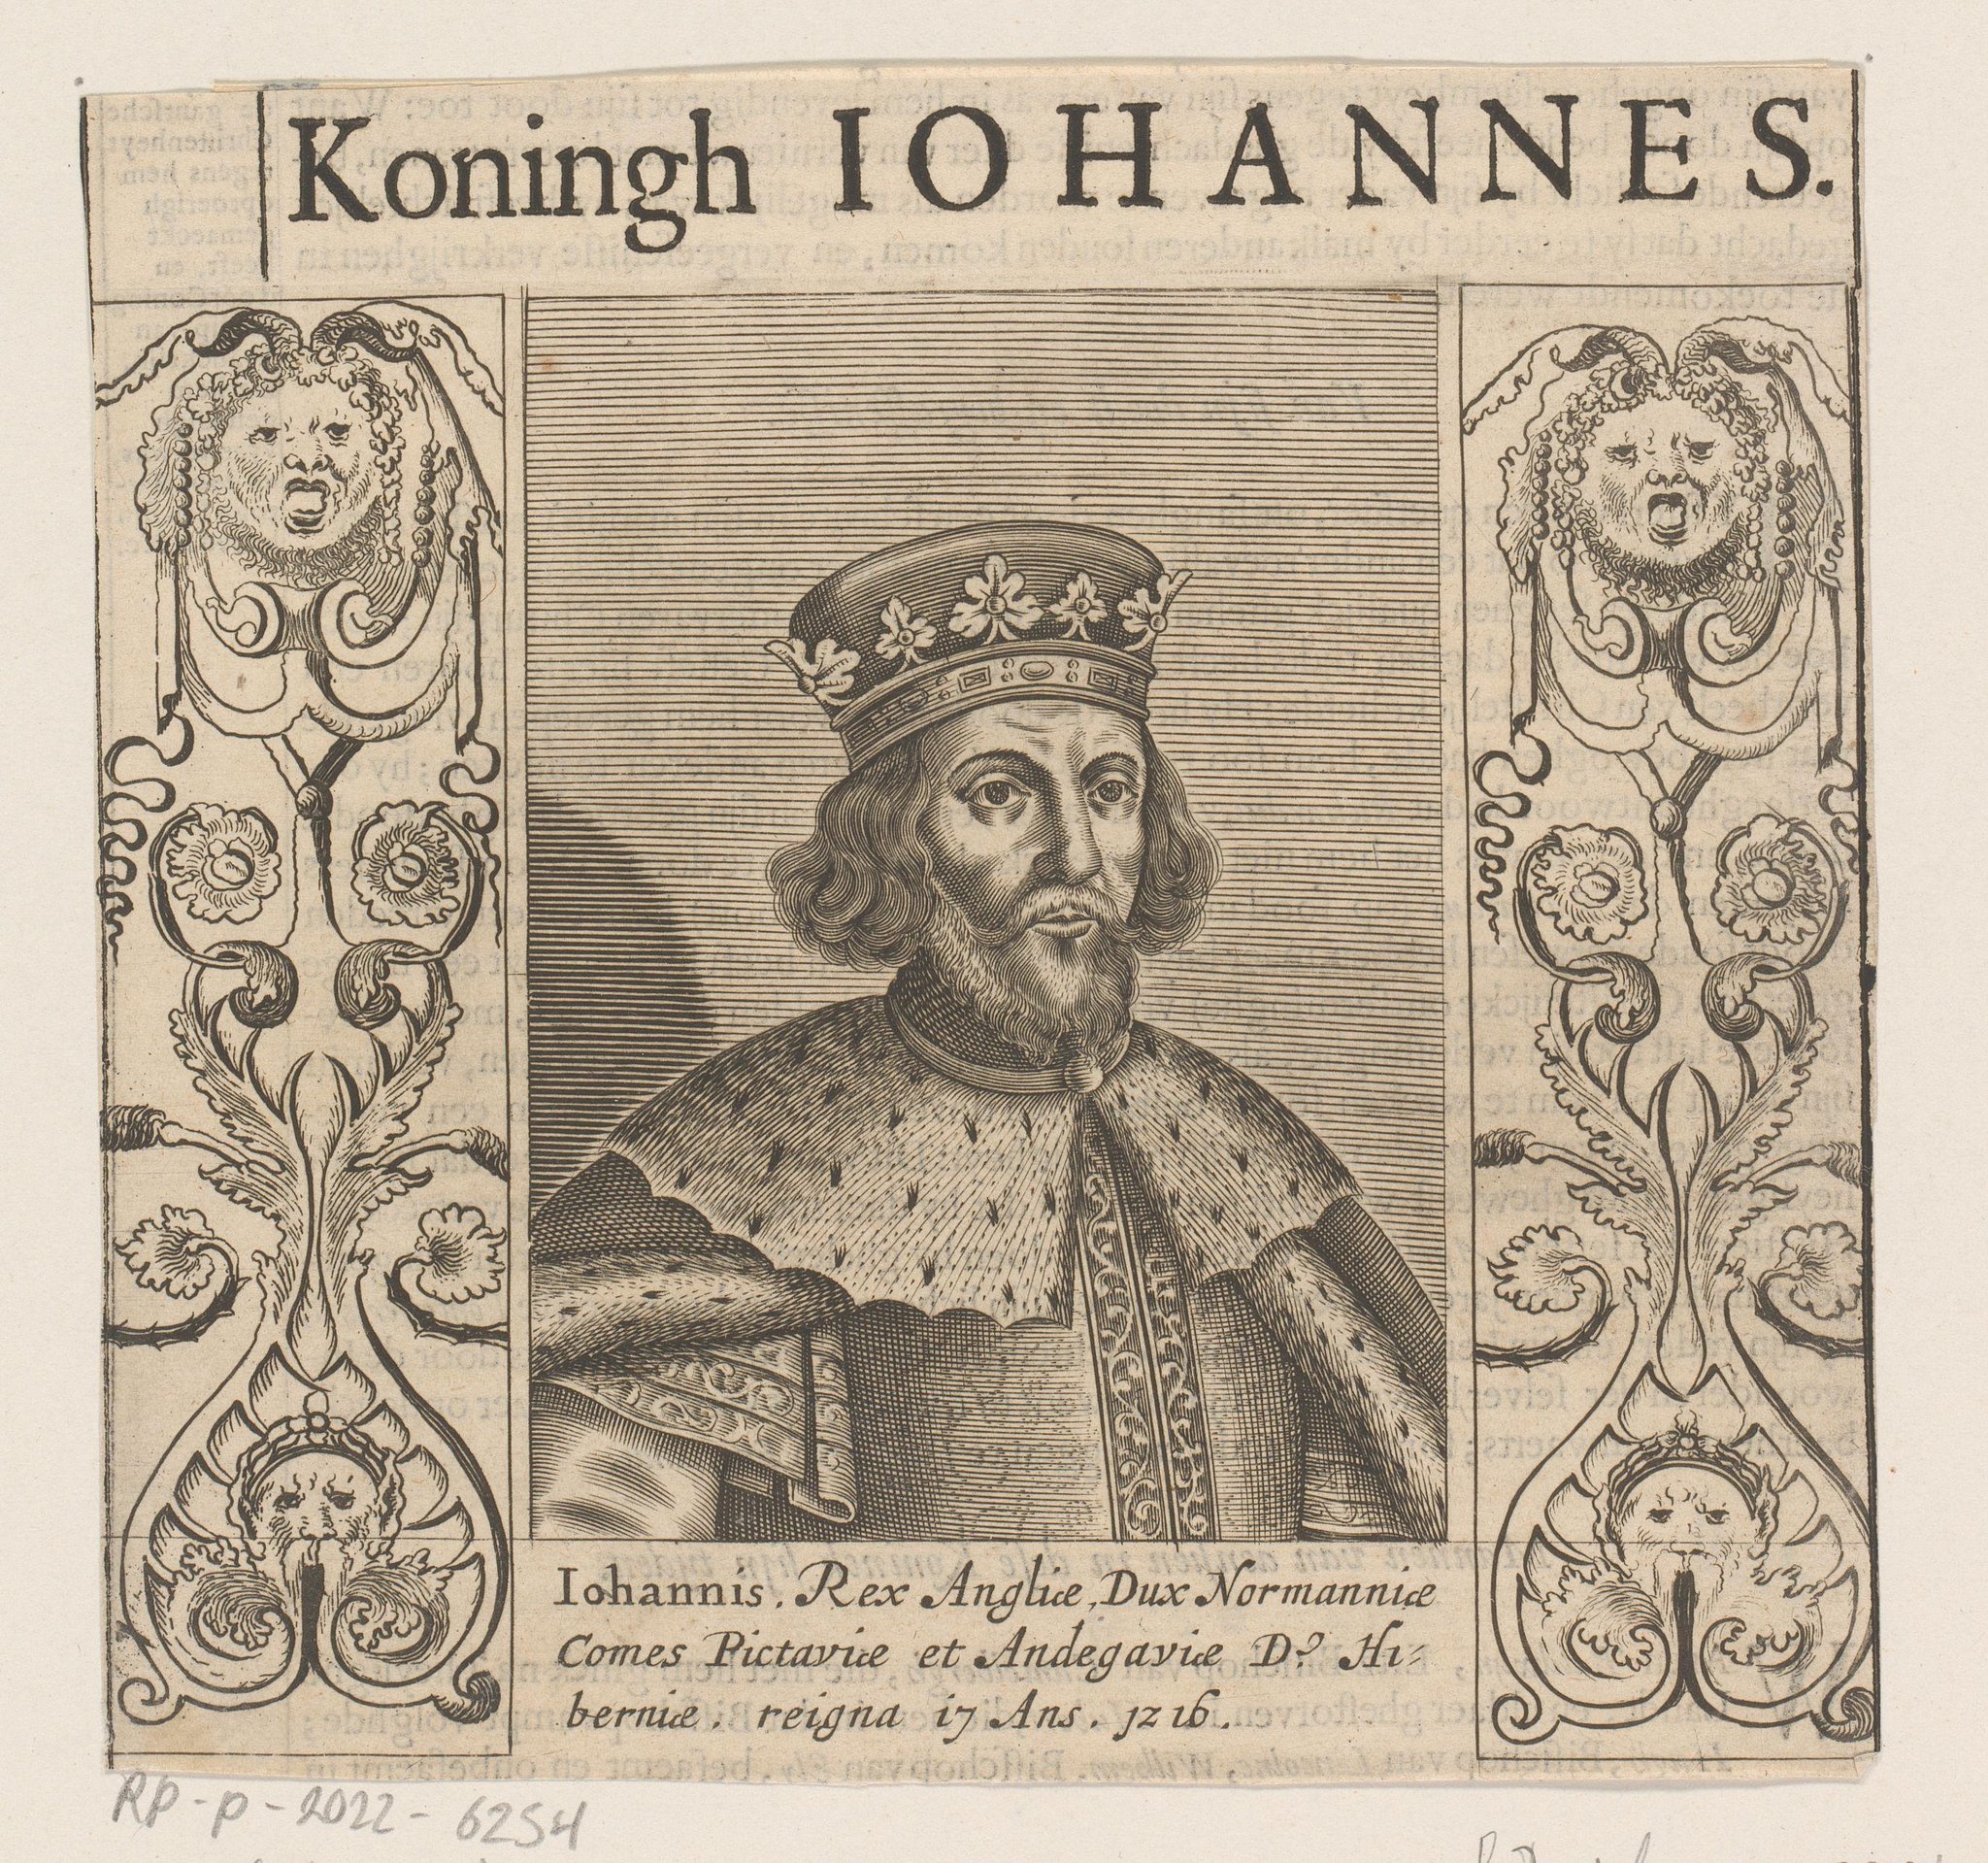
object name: print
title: Portret van Jan zonder Land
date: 1649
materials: paper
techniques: engraving, etching, letterpress printing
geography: amsterdam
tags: historical persons, king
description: Prent uit: Baker, Sir Richard. Cronyke van het Leven en Bedryff van alle de Coningen van Engeland. (...). Amsterdam: Cornelis Danckerts, 1649, dl. 1.